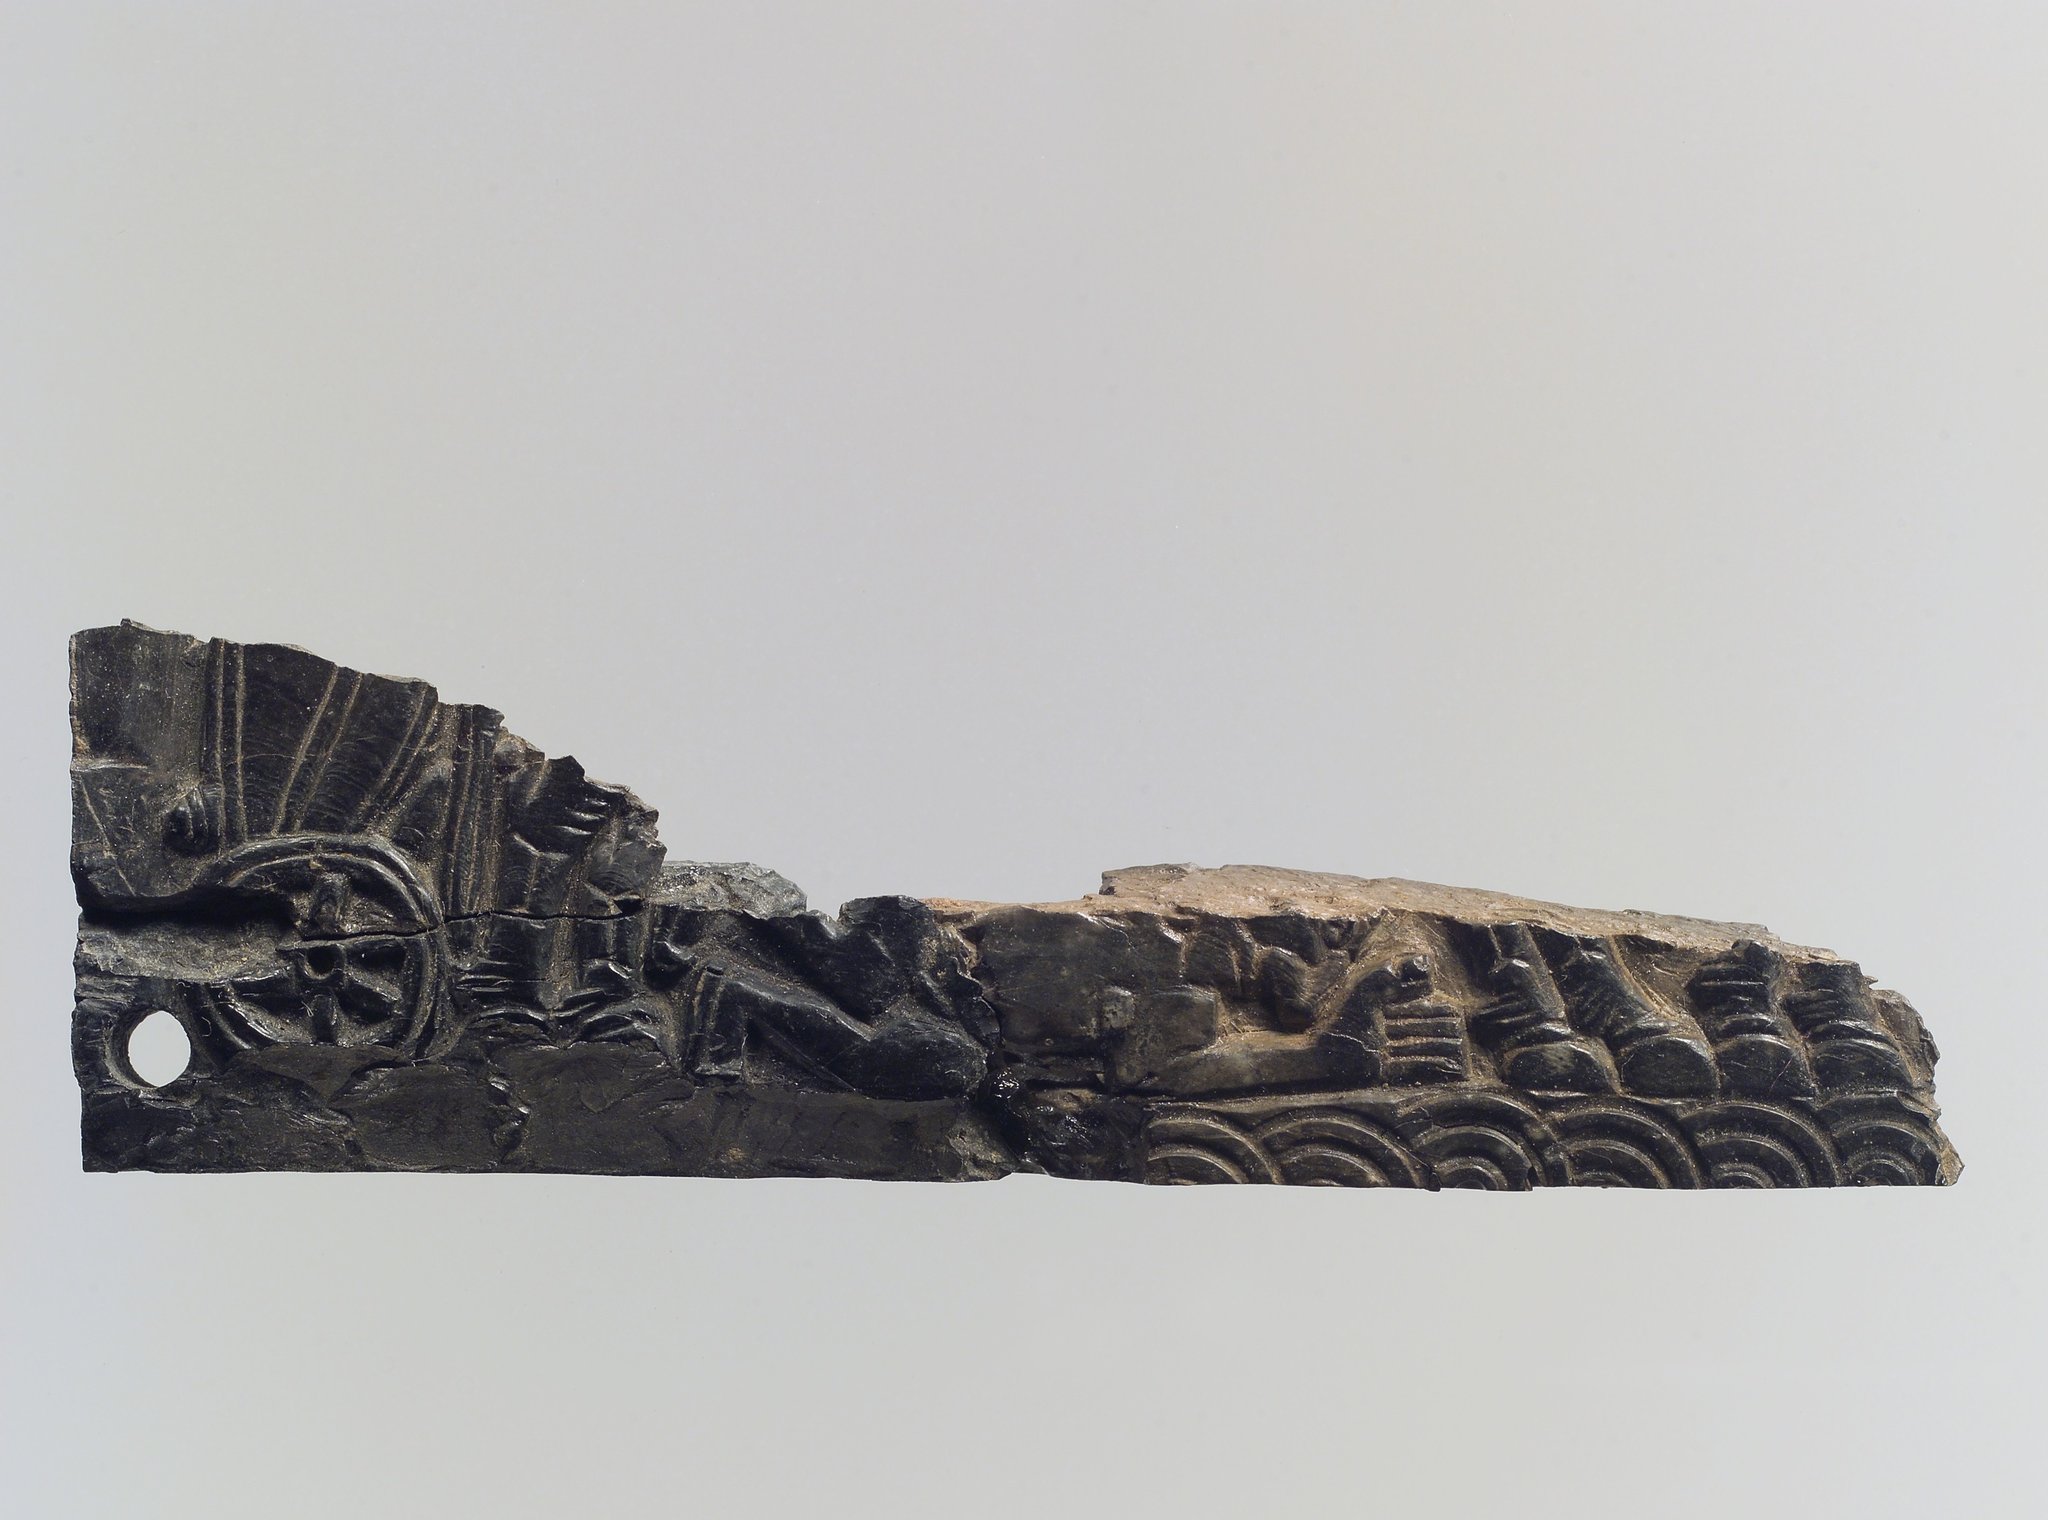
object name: relief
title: Plaque fragment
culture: iranian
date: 900-801 BCE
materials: ivory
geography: iran